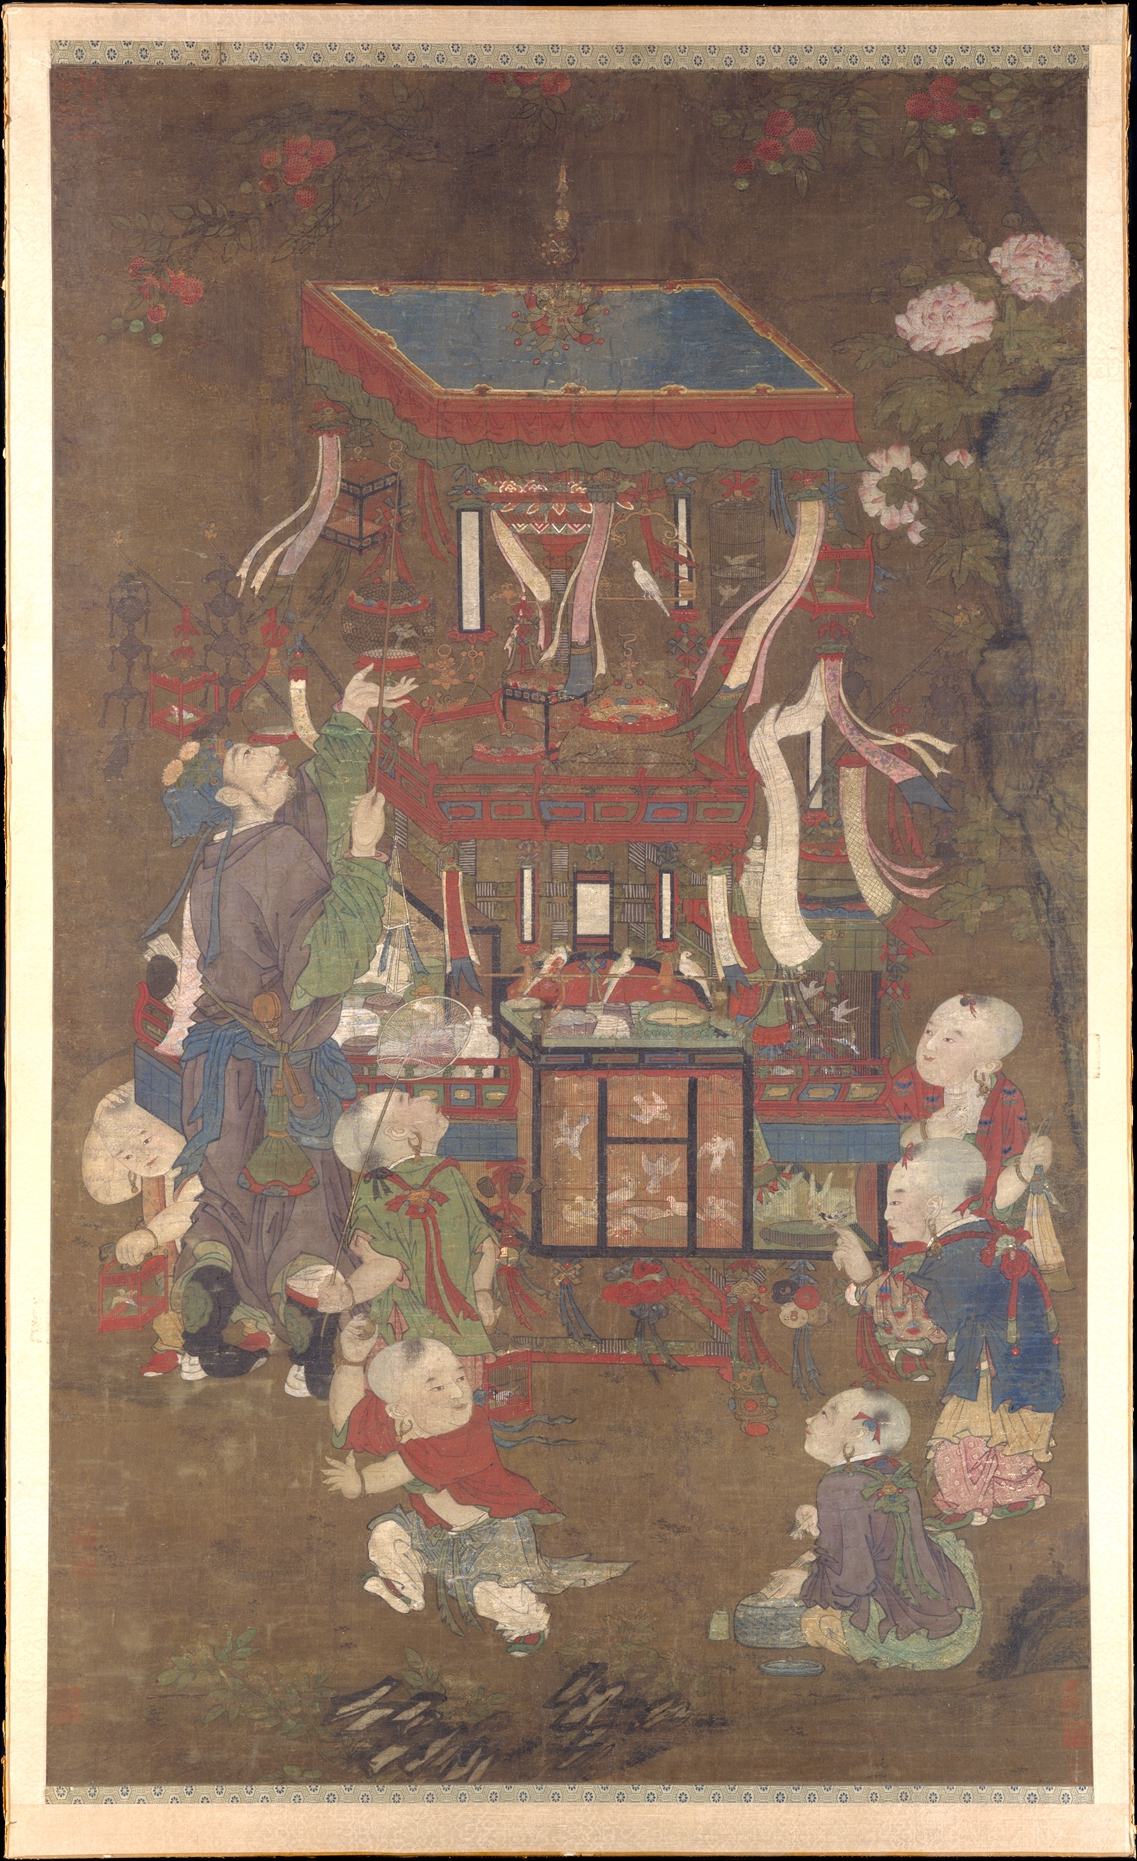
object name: hanging scroll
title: Bird peddler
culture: chinese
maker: unidentified artist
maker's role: artist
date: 1467-1533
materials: ink, silk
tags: birds,boys,men,merchants